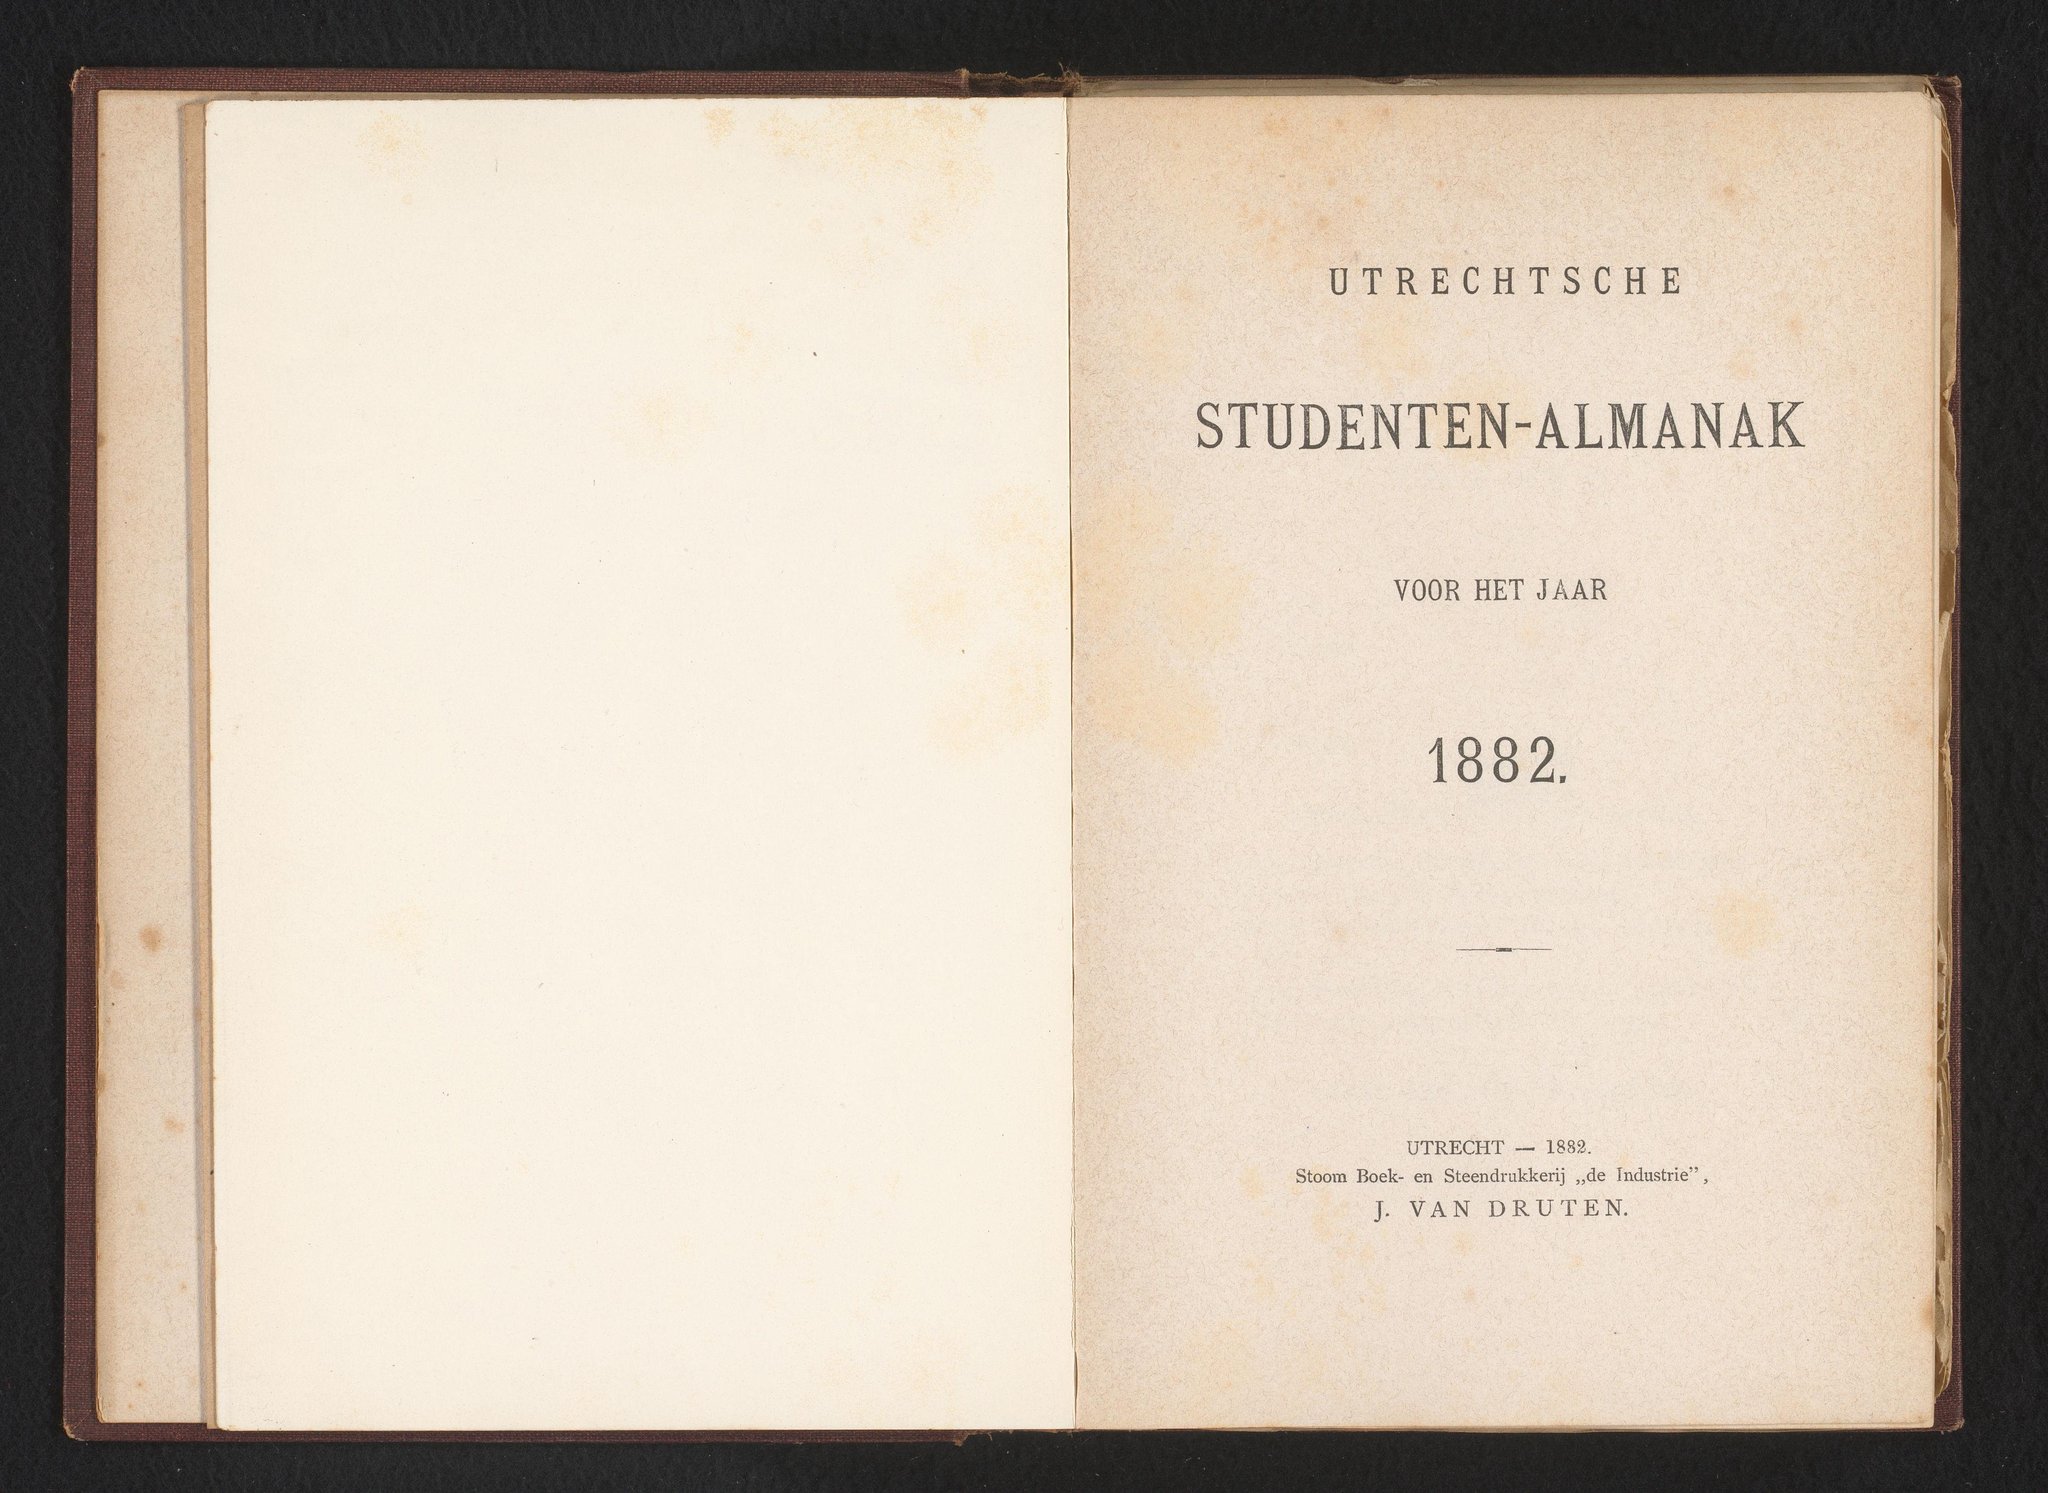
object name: book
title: Utrechtsche studenten-almanak voor het jaar 1882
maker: j. van druten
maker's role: publisher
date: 1882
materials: paper, cardboard, linen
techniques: albumen print, letterpress printing, lithograph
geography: utrecht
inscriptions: number: ‘450’